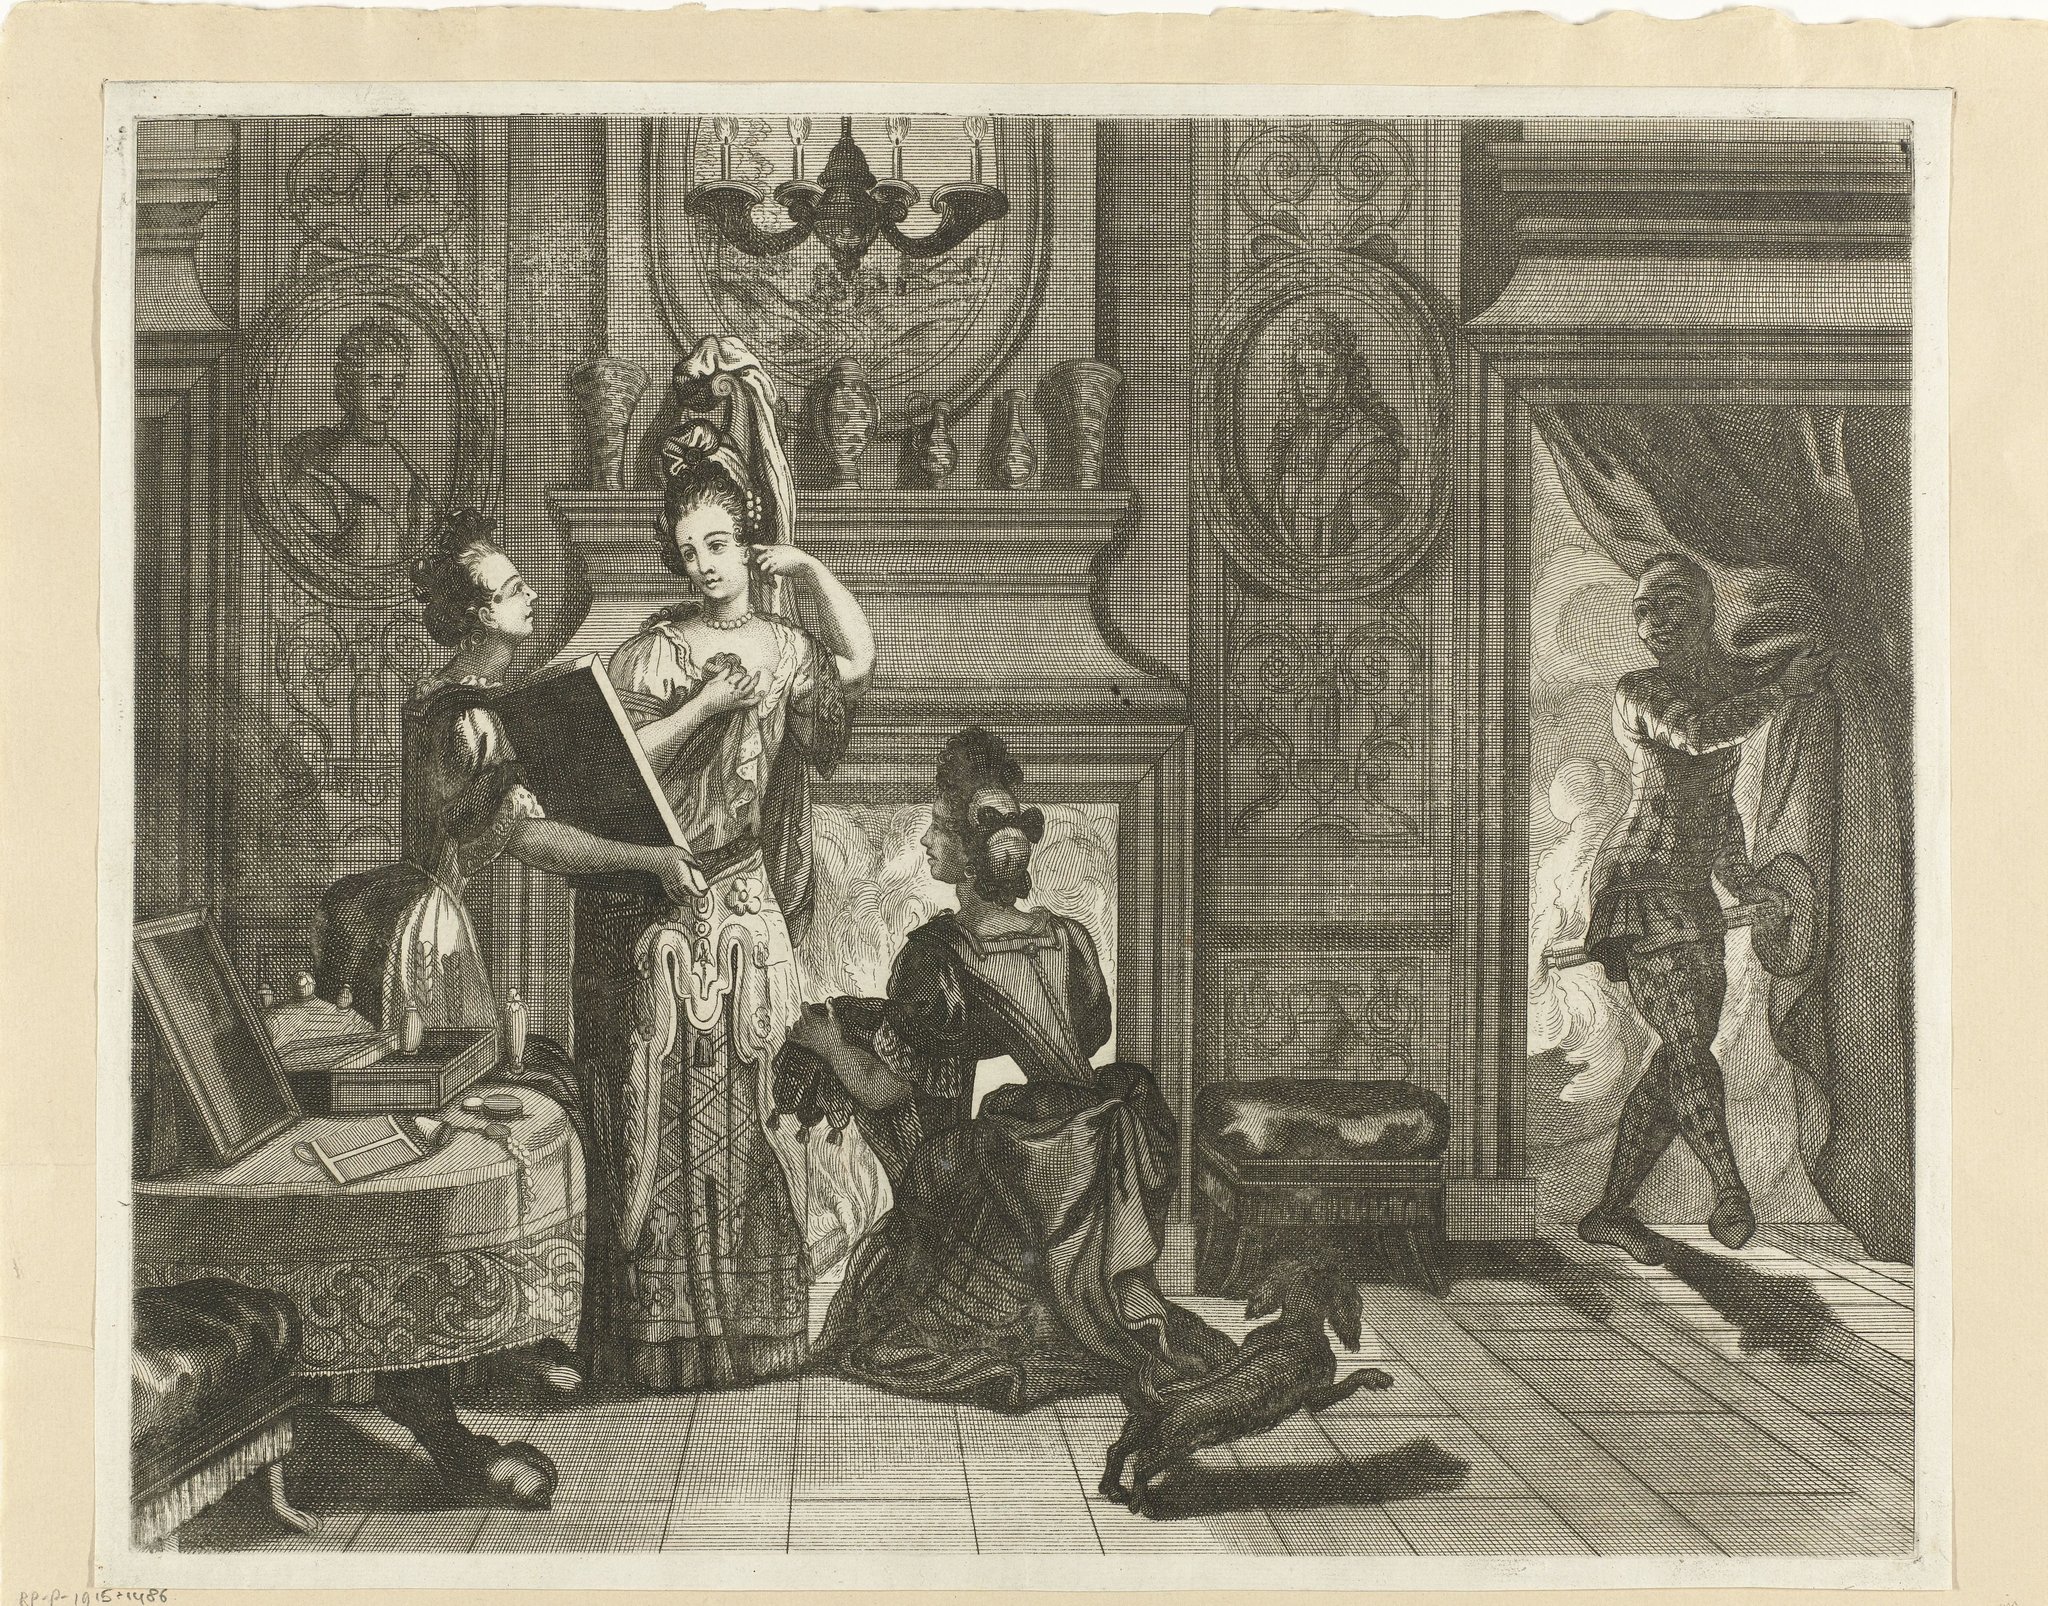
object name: costume print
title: Maskerade-gangers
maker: Anonymous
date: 1685-1700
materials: paper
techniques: engraving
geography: france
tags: festivities (+ costume party ~ festive activities), making toilet, mirror - aa - (for) women, clothes, costume (+ women's clothes), bedroom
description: Een vrouw in een vertrek voor een open haard. Ze maakt toilet voor het bal. Een kamenier houdt haar een spiegel voor waarin ze haar hoge kapsel bekijkt. Een tweede kamenier zit geknield voor haar en houdt haar japon op. Door de deur rechts komt een man in harlekijnskostuum (travesti?) binnen. Tegenzijdige kopie zonder onderschrift naar prent uitg. door Jan vander Bruggen, met onderschrift "Femme de qualité s'habillant pour Coure le Bal ".